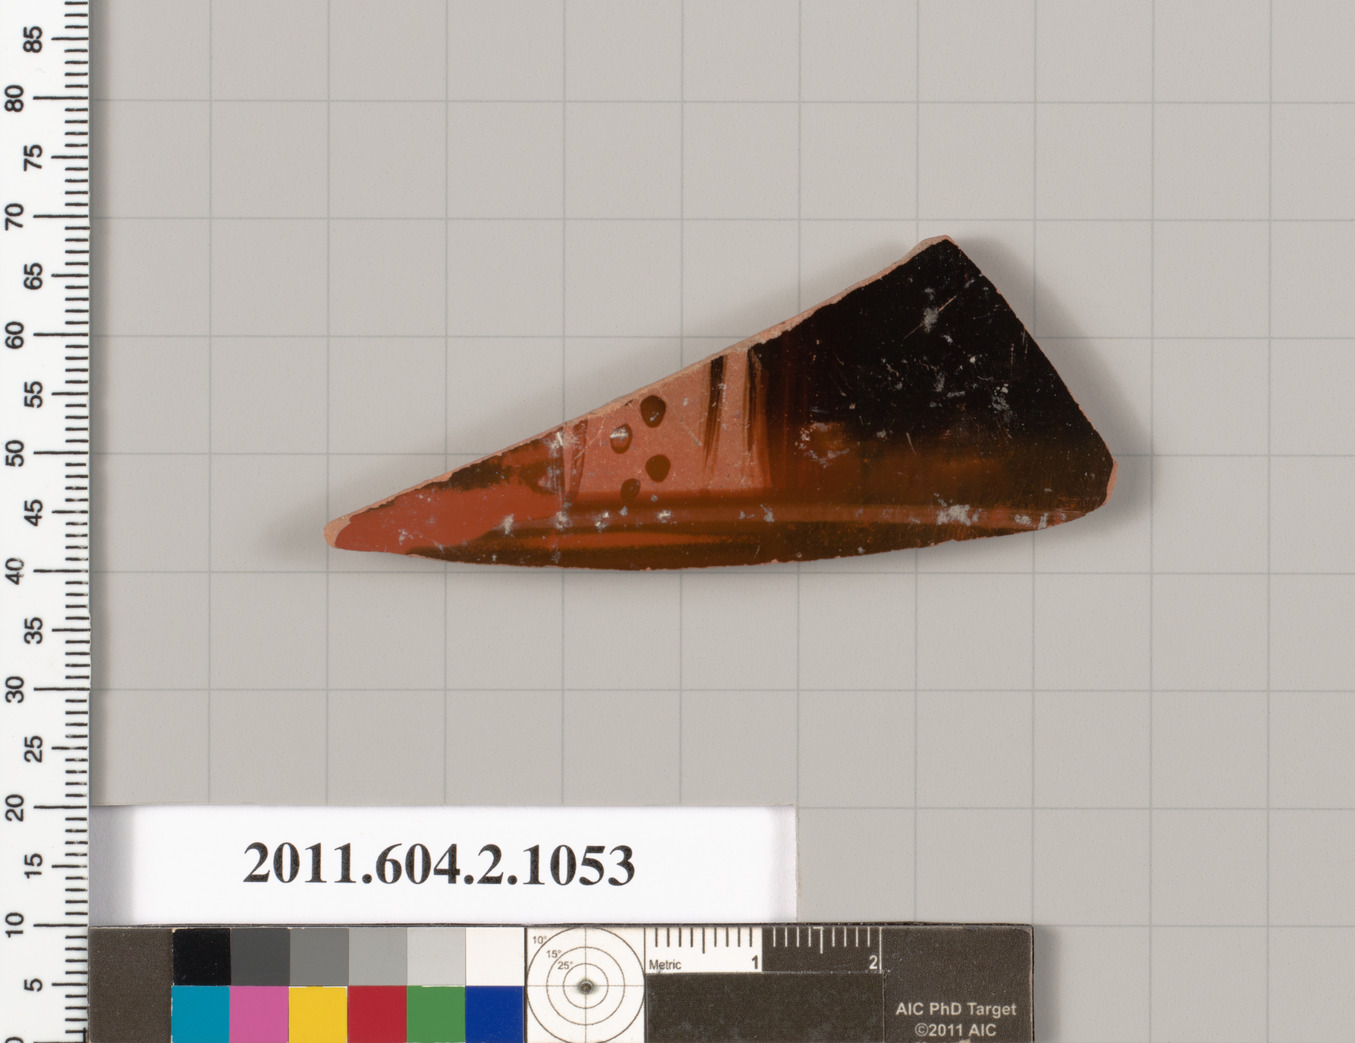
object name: pelike fragment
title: Terracotta fragment of a pelike (jar)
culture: greek, attic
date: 450-426 BCE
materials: terracotta